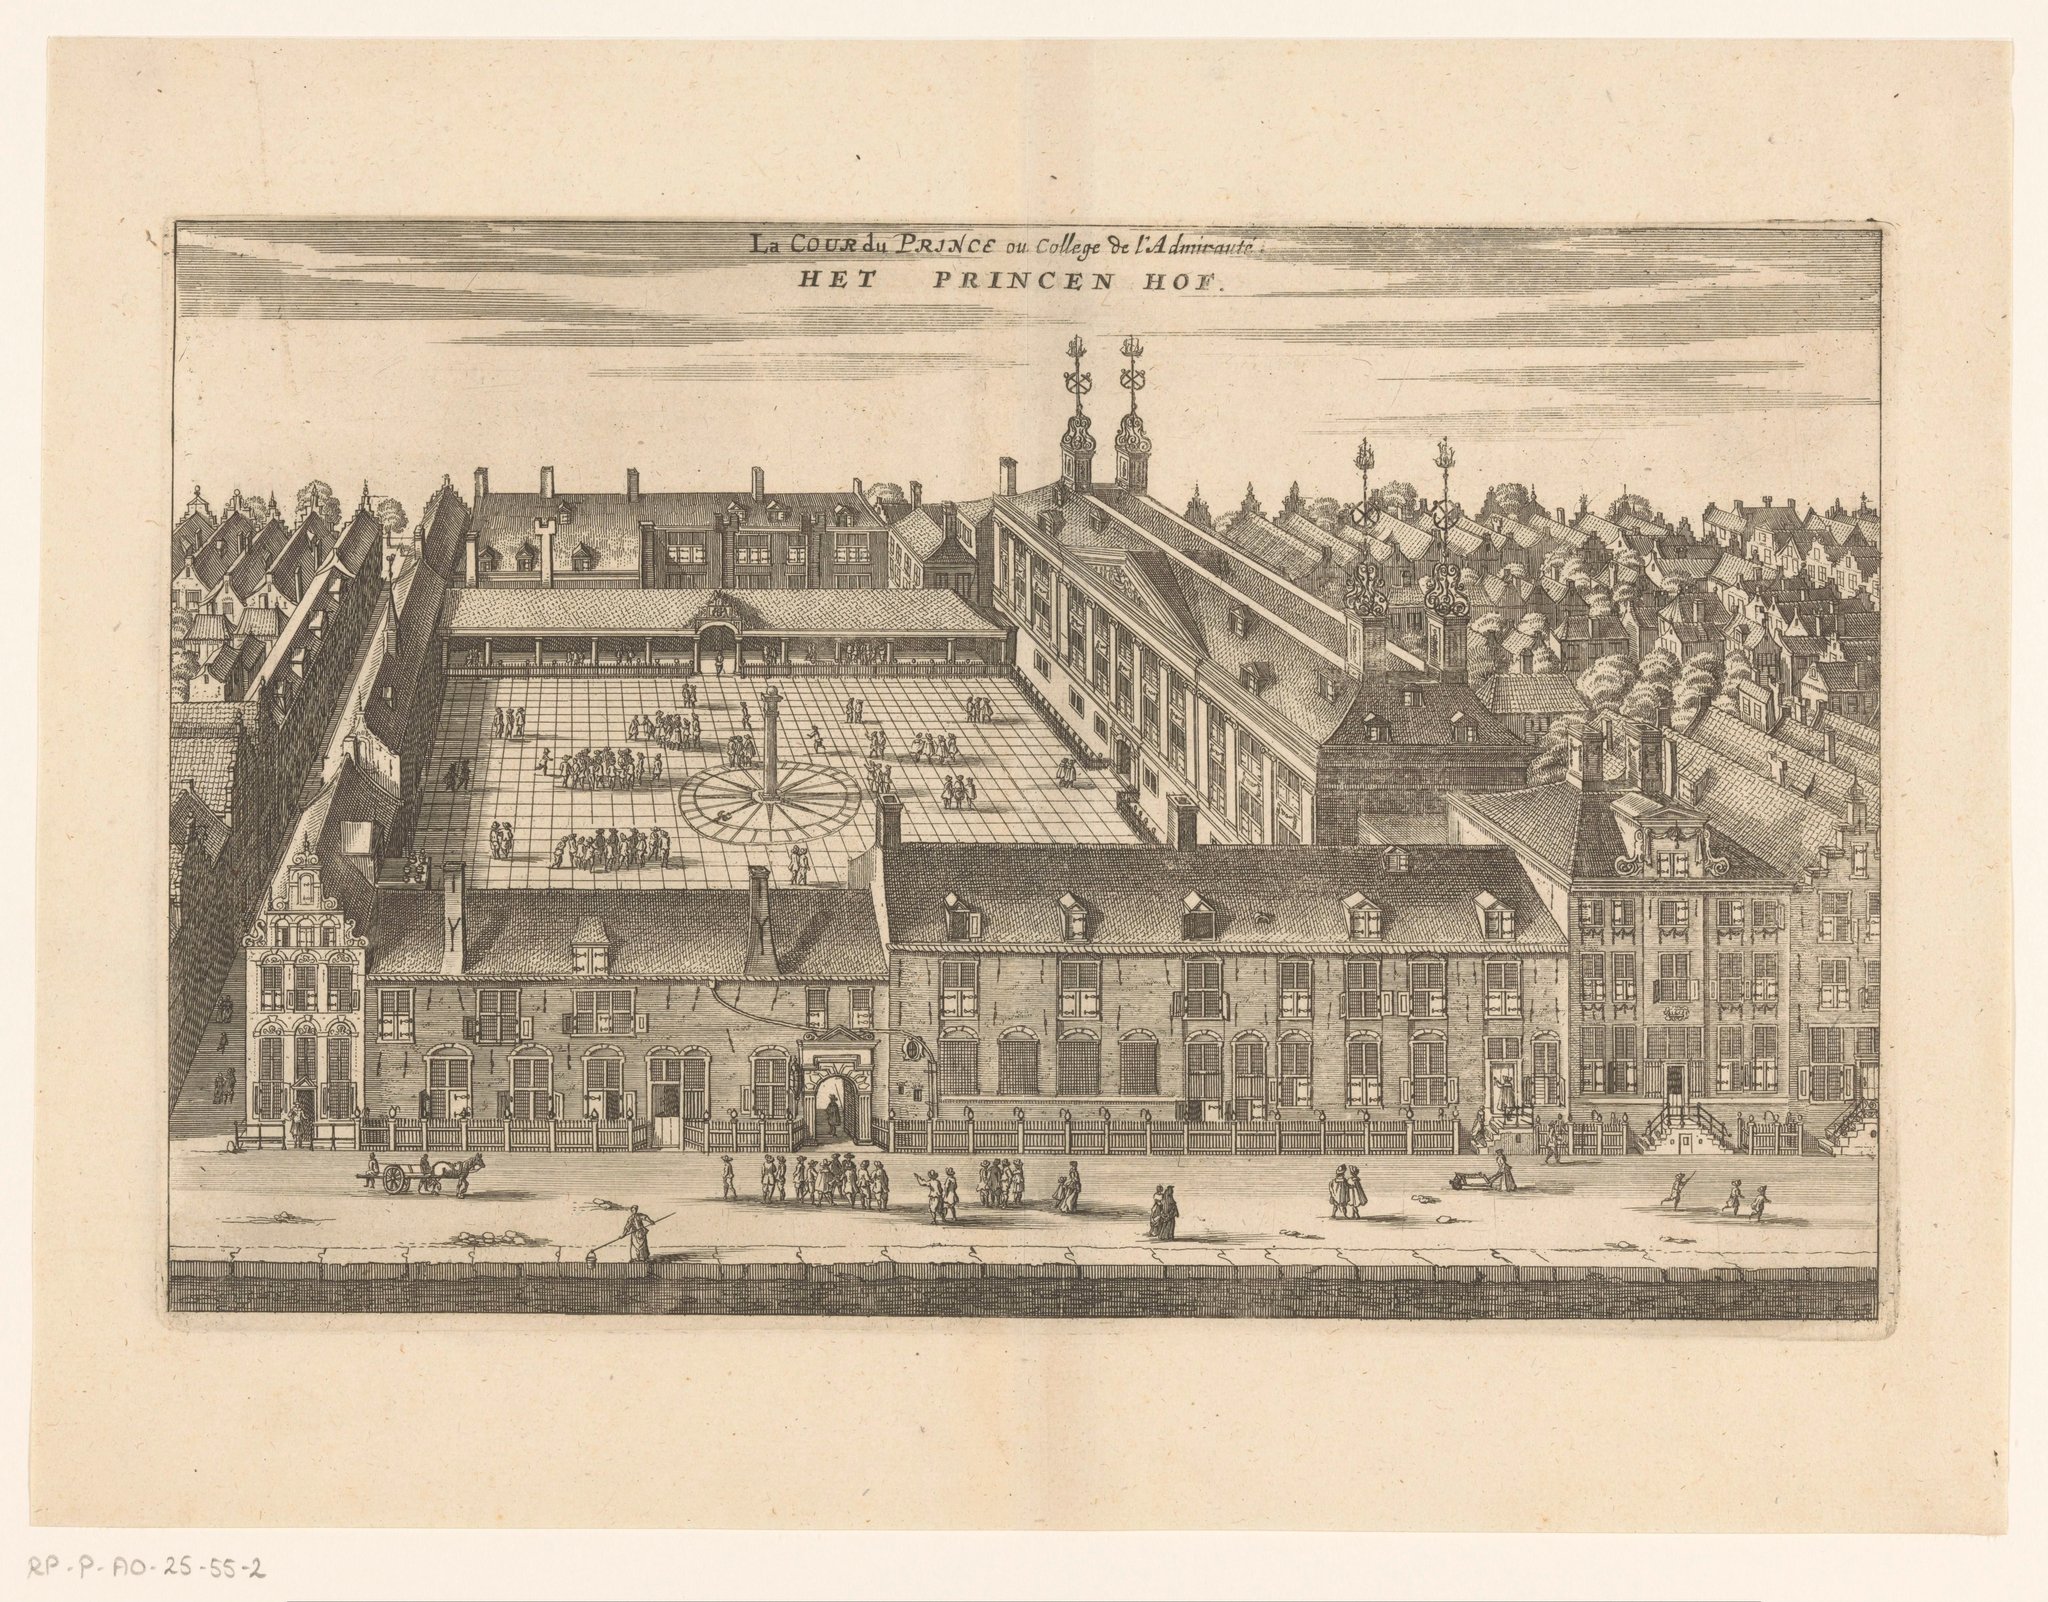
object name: book illustration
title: Gezicht op het Prinsenhof te Amsterdam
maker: jacob van meurs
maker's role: draughtsman, print maker, publisher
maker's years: 1619-1680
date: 1663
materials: paper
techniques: engraving, etching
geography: amsterdam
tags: courtyard, exterior ~ representation of a building, street (+ city(-scape) with figures, staffage)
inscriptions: collector's mark: Lugt 2228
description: Huidige staat van prent ook gebruikt in: Dapper, Olfert. Historische beschryving der stadt Amsterdam: waer in de voornaemste geschiedenissen (na een kort verhael van gansch Hollant en d'omleggende dorpen (…). Amsterdam: Jacob van Meurs, 1663.* * In sommige exemplaren van deze uitgave komt de huidige staat van de prent voor. In andere exemplaren is een eerdere staat ingebonden, met alleen de Nederlandse titel (zie RP-P-AO-25-55-1).